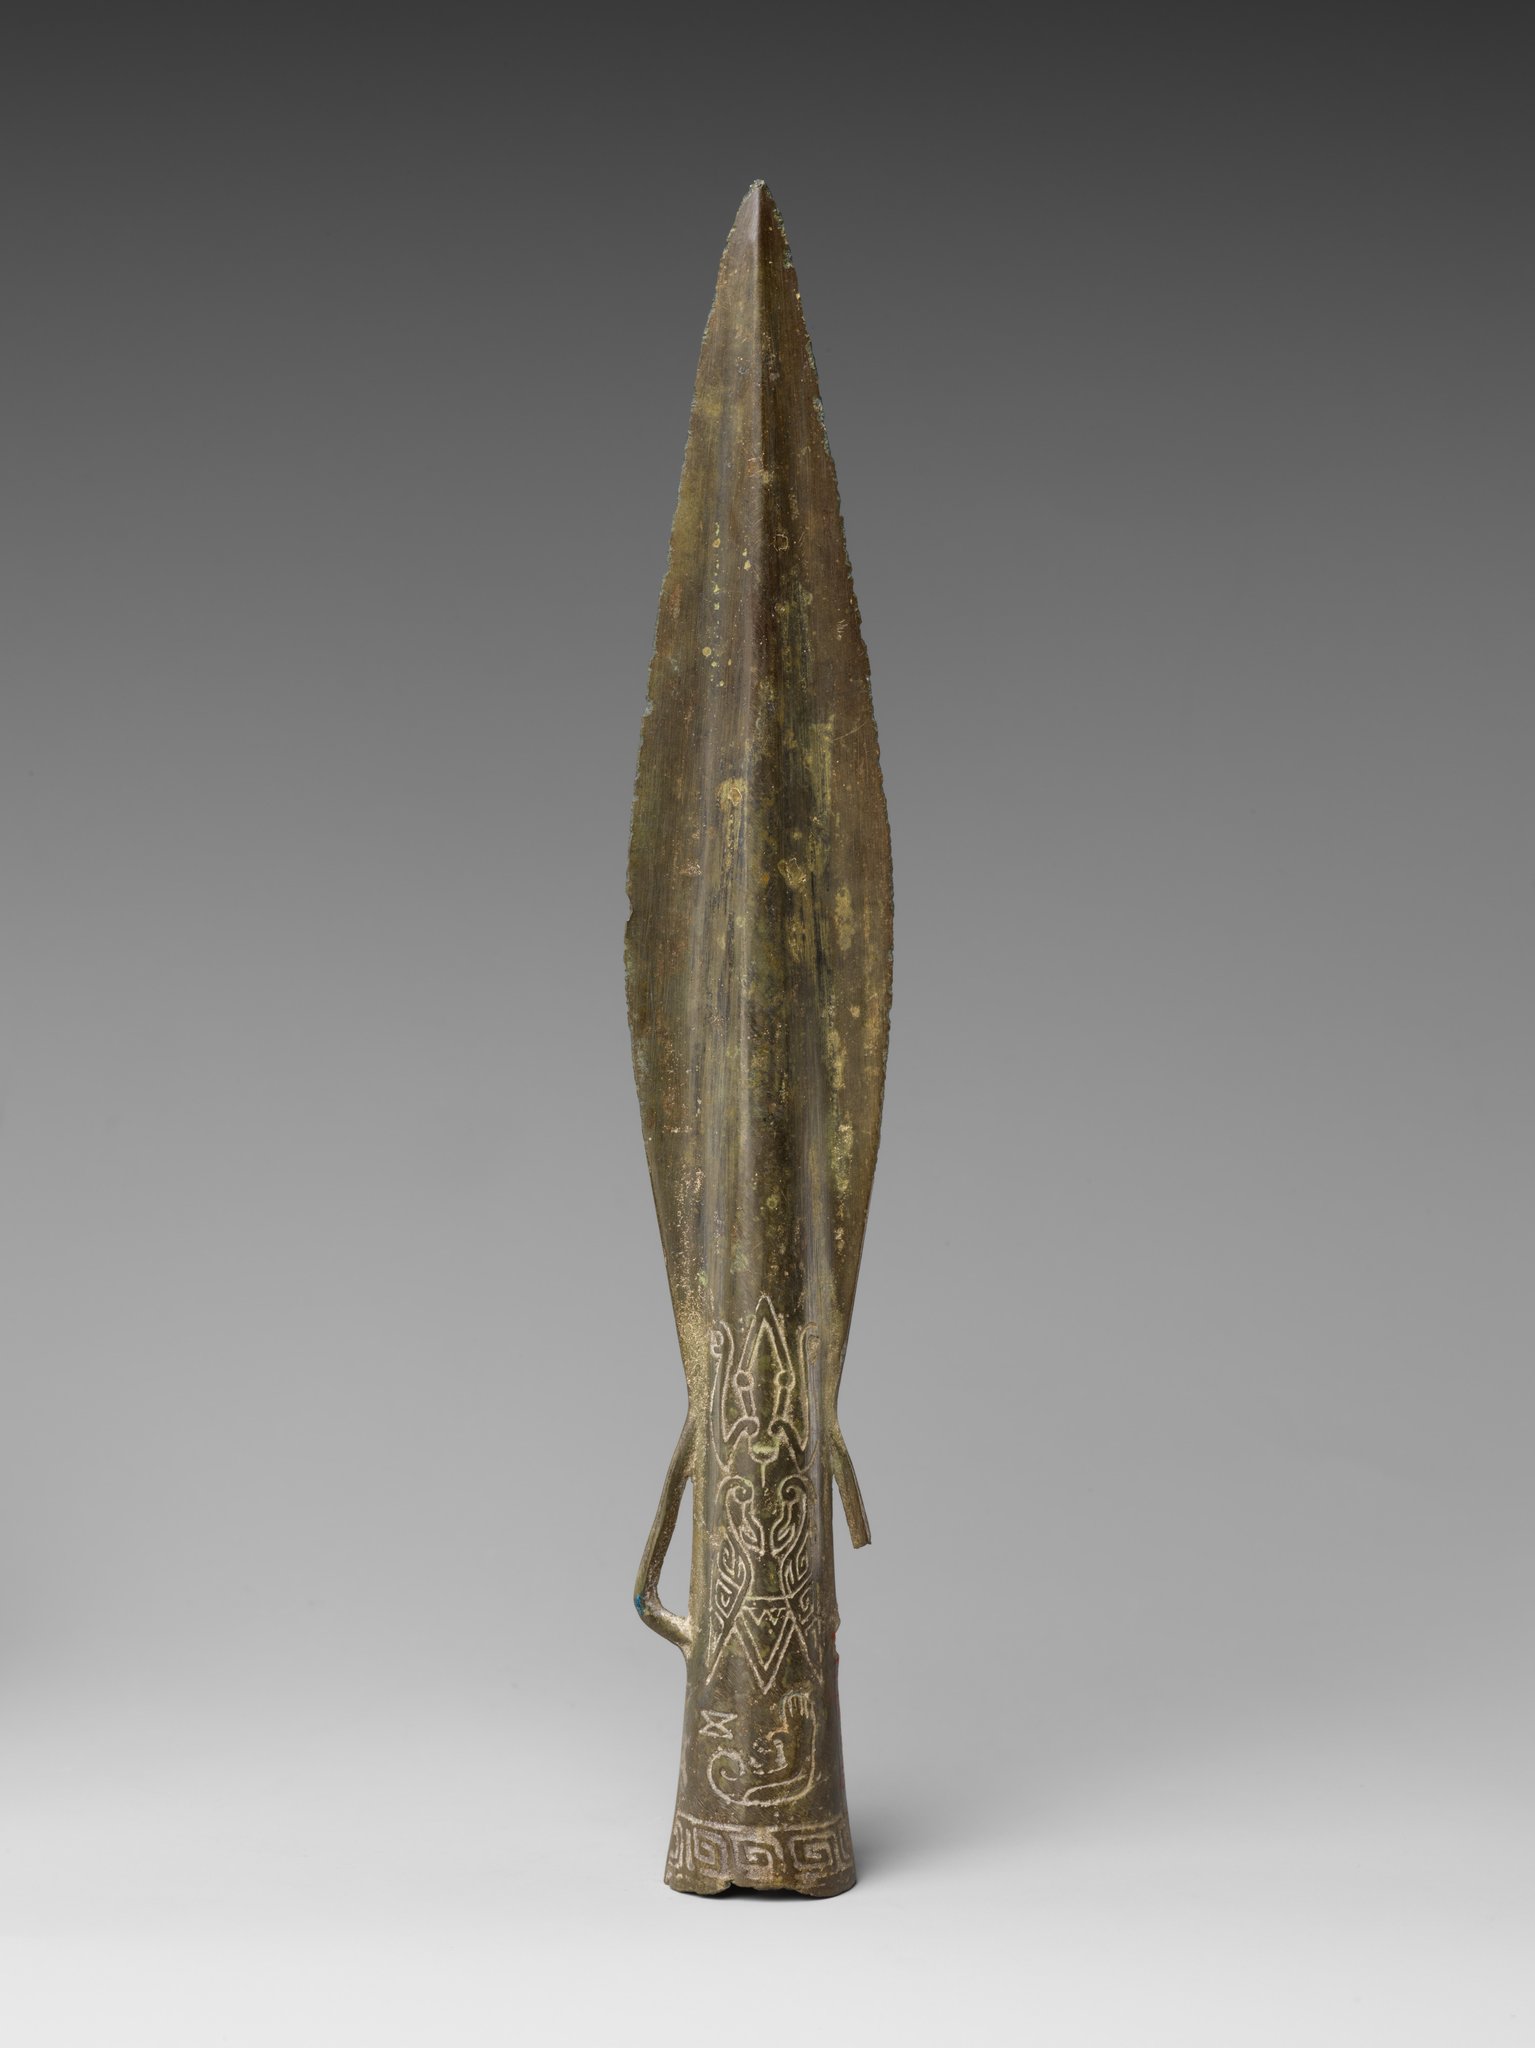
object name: spearhead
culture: chinese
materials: bronze